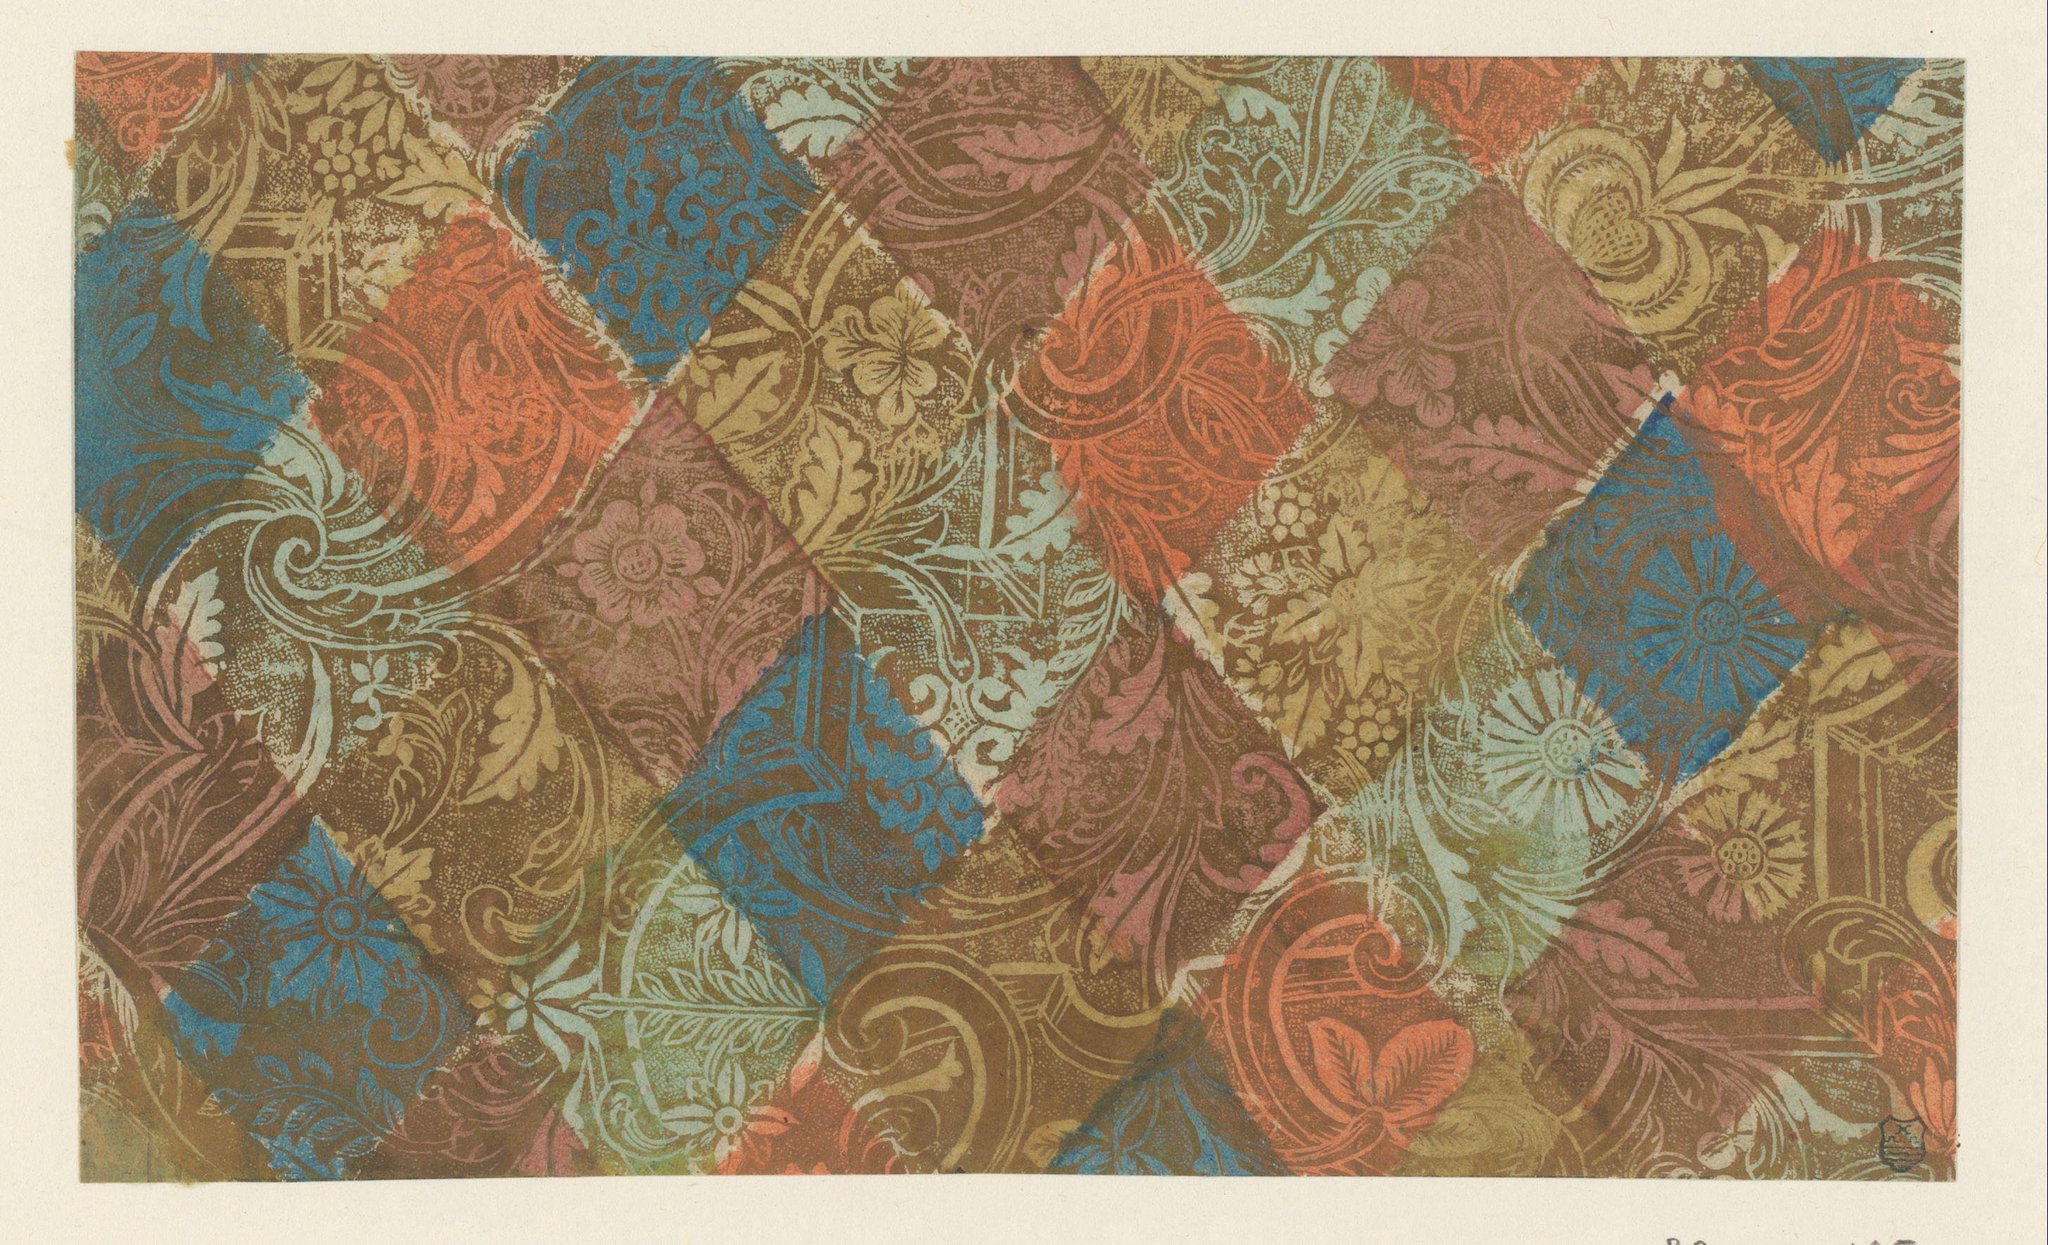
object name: brocade paper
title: Blad met Lodewijk XIV-ornament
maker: Anonymous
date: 1750-1850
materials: gold leaf, paint, paper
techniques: relief print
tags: ornament ~ geometric motifs, ornament derived from plant forms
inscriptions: collector's mark: Lugt 2760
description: Blad met Lodewijk XIV-ornament, bandwerk, ranken met bloemen en vruchten.